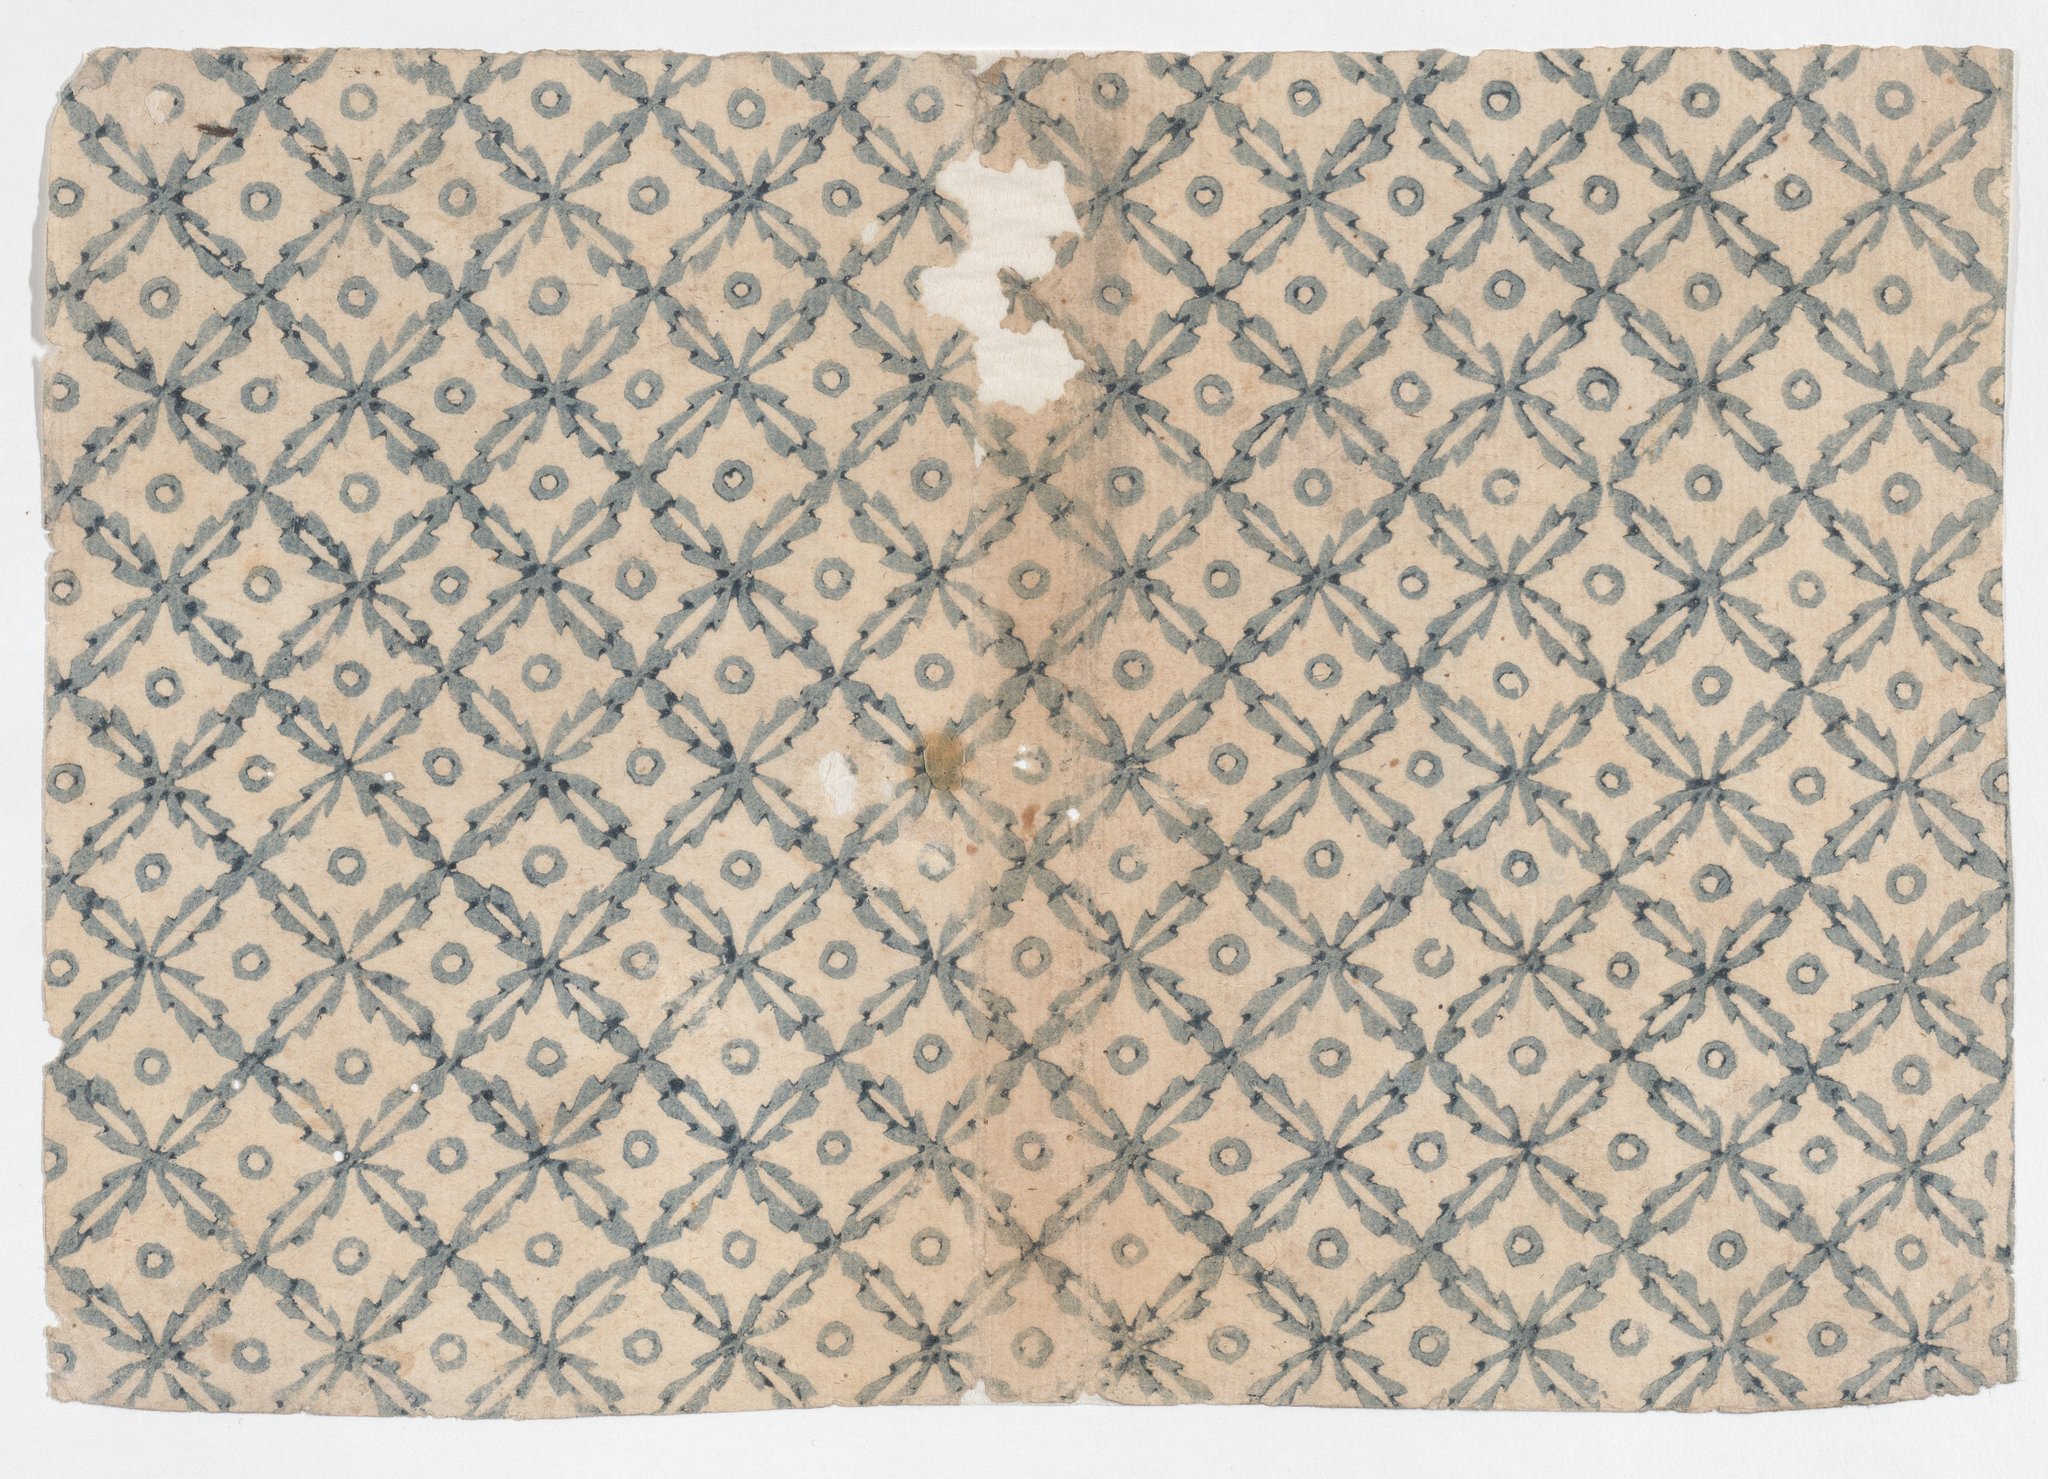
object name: print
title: Sheet with overall pattern of flowers and circles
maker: Anonymous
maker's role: artist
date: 1801-1900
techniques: relief print